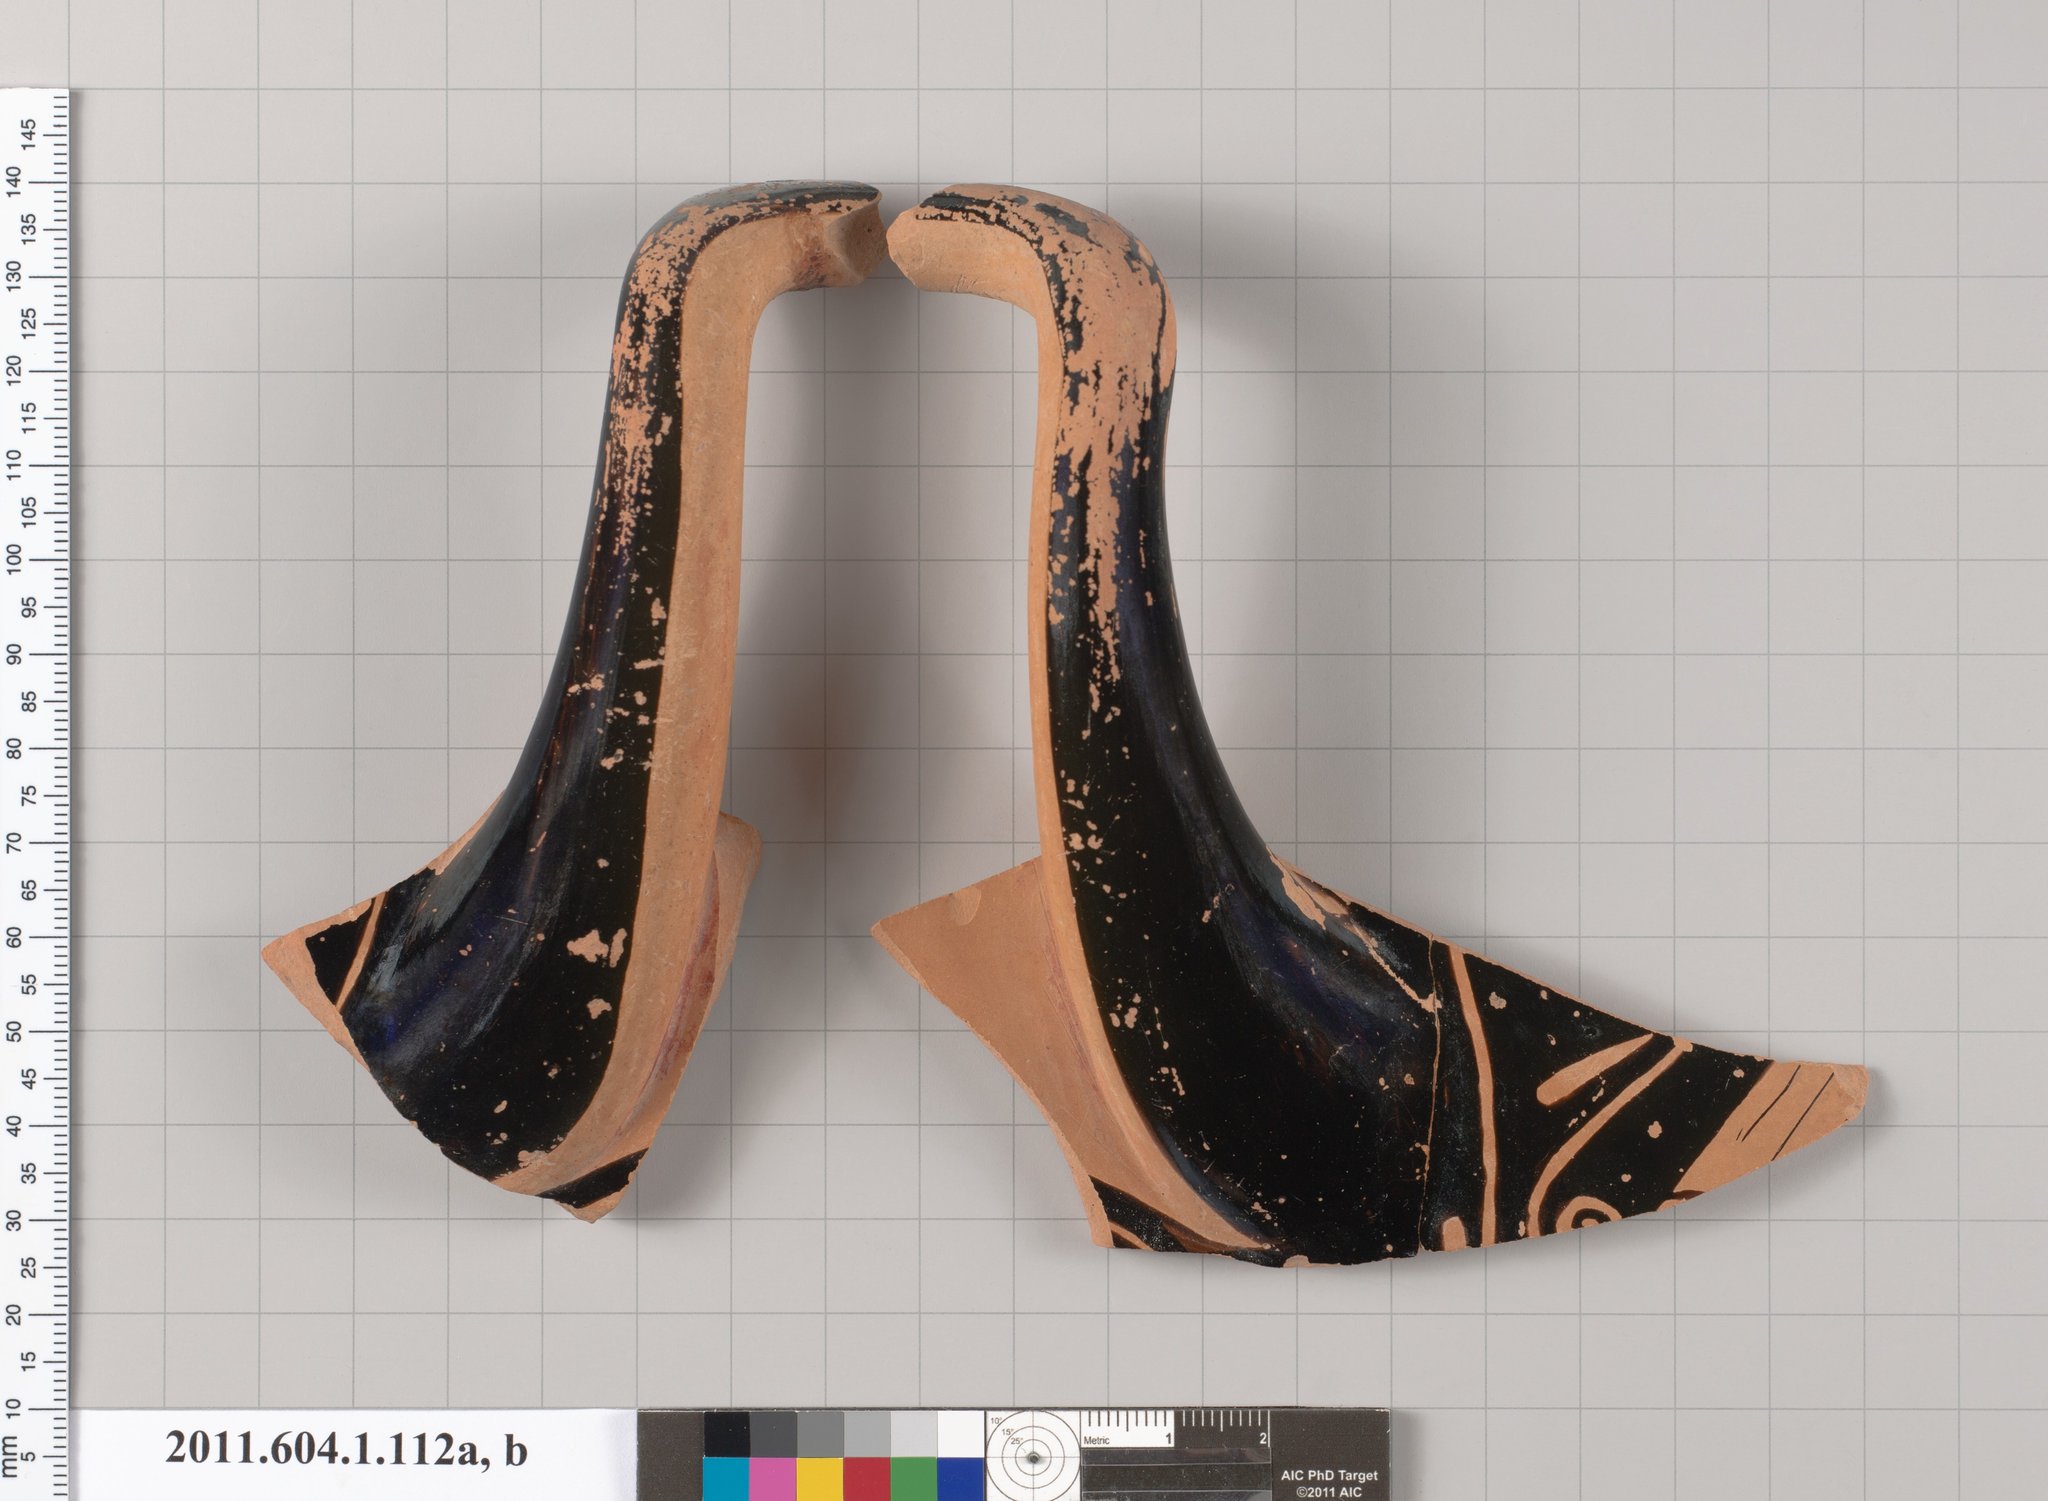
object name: kylix fragment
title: Terracotta fragments of a kylix (drinking cup)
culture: greek, attic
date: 470-450 BCE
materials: terracotta